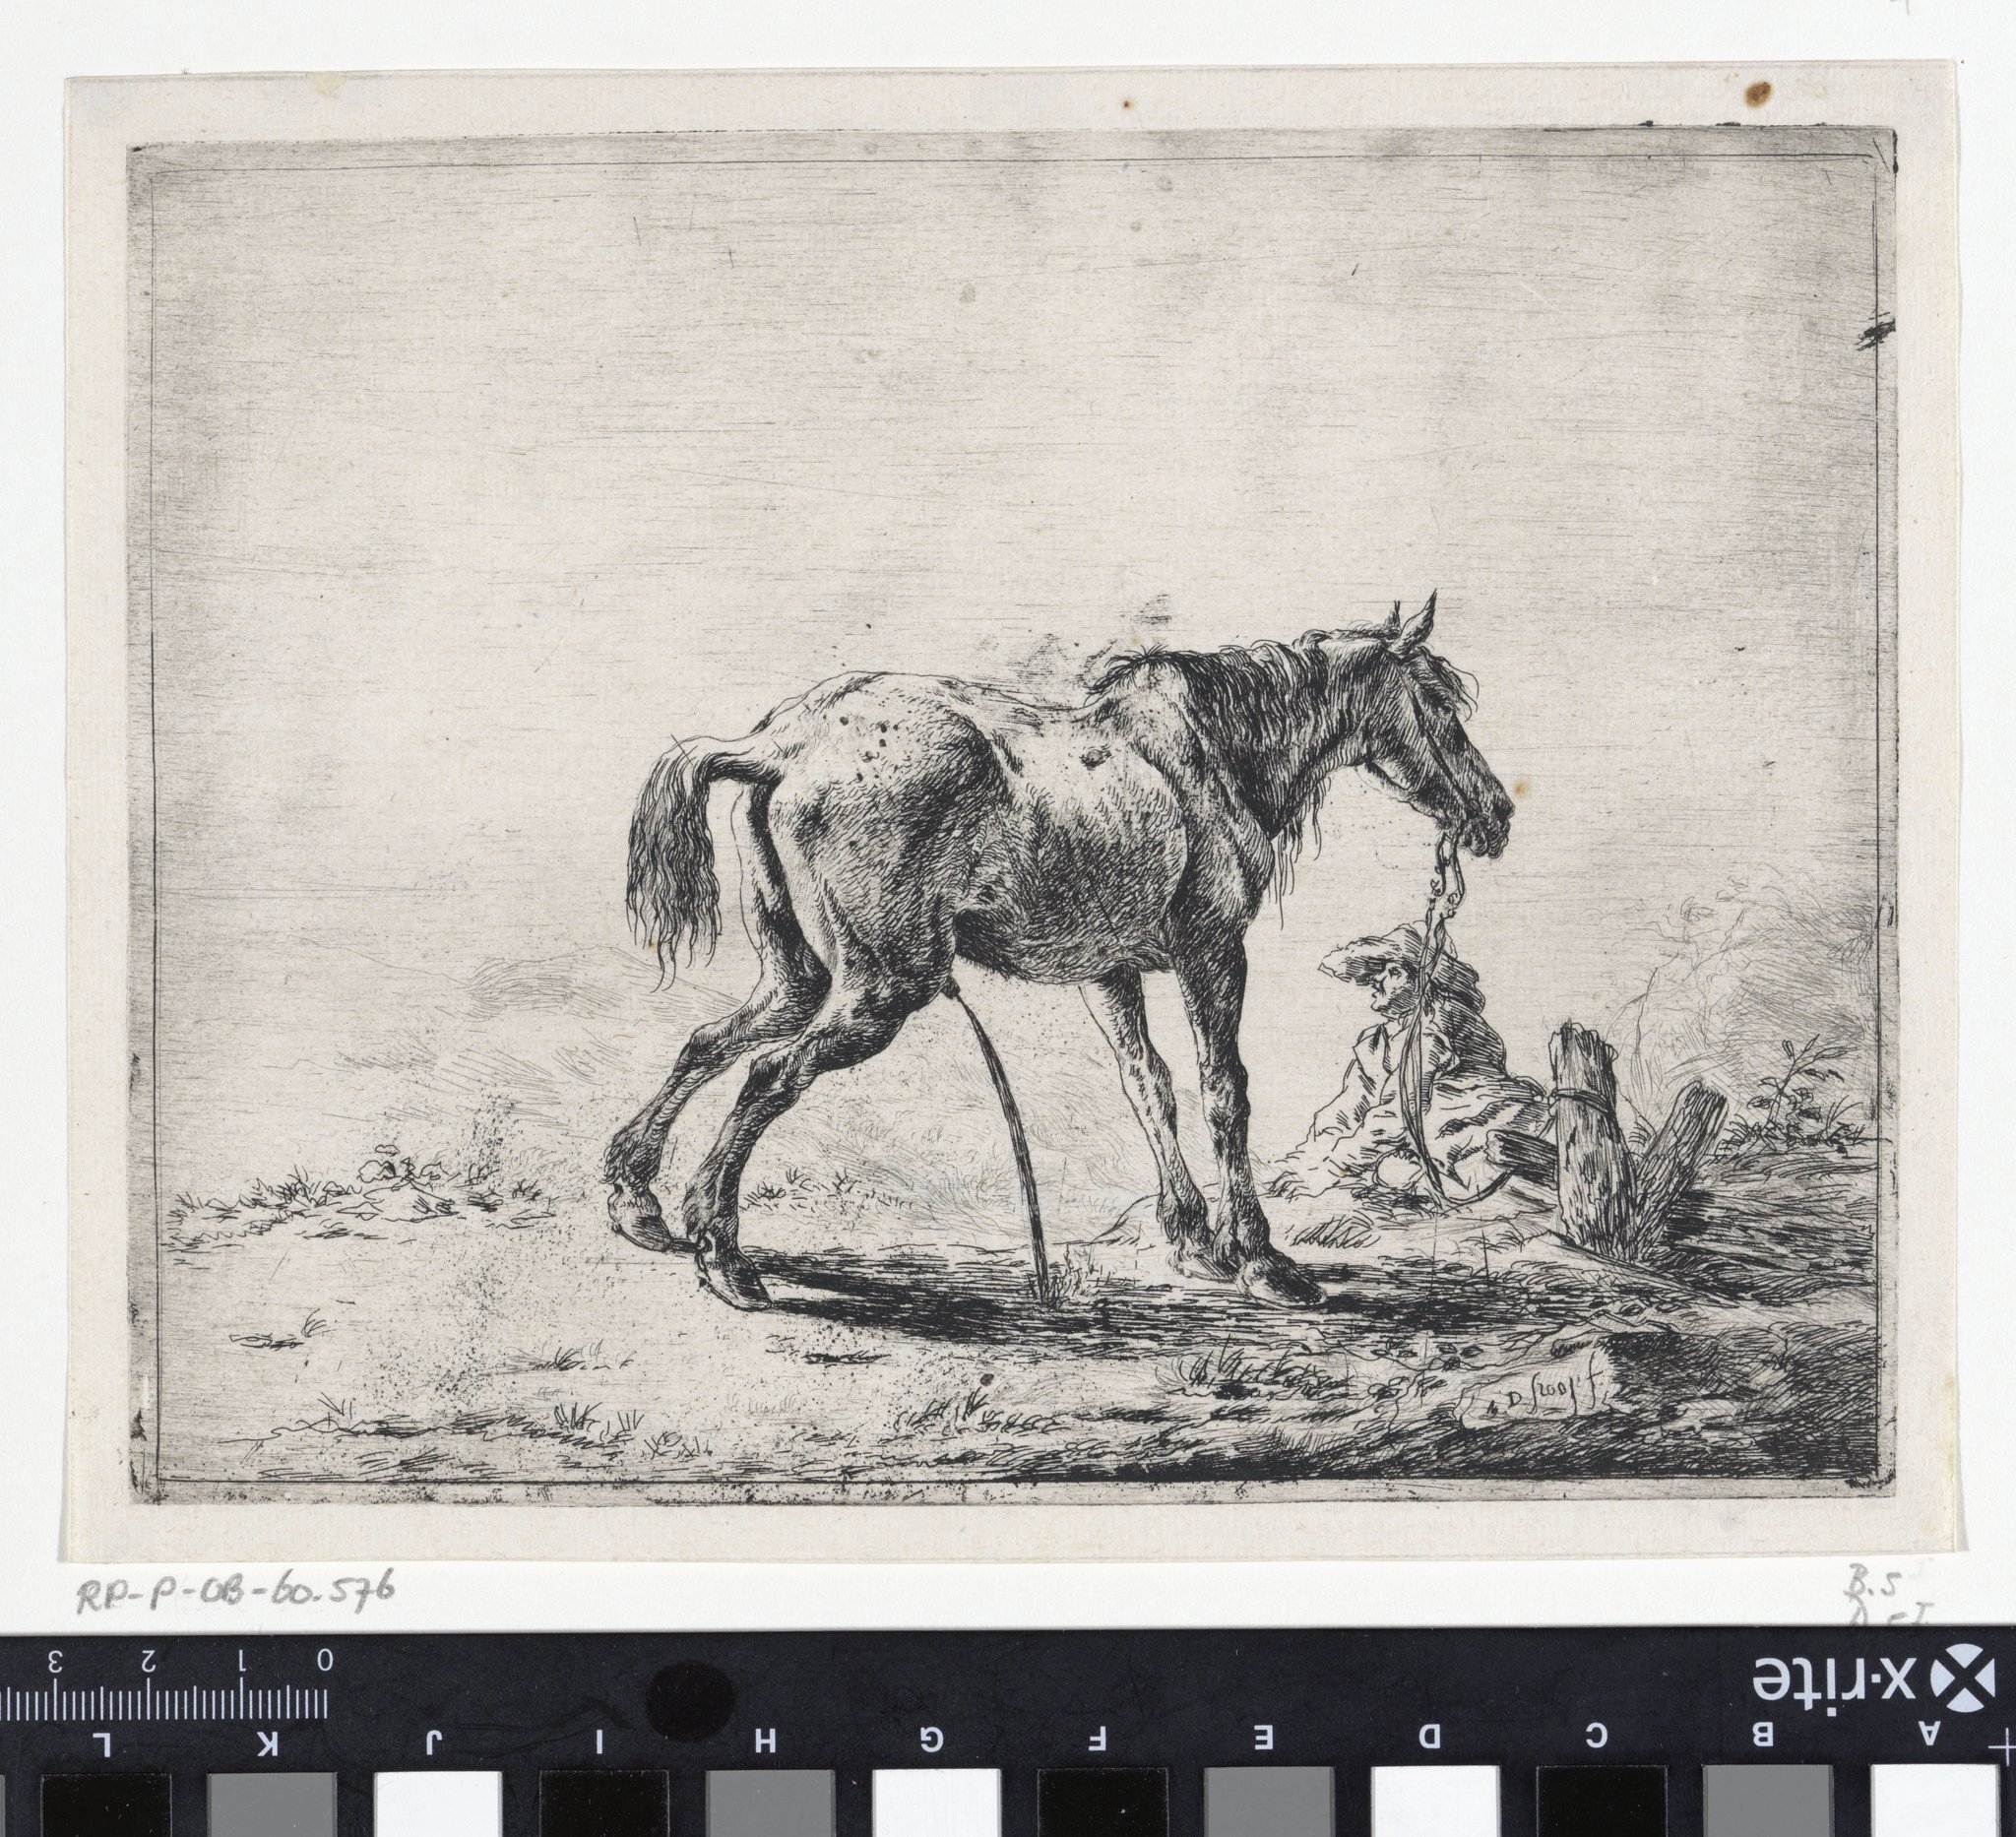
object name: print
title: Paarden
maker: dirk stoop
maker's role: draughtsman, painter, print maker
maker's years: 1615-1686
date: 1651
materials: paper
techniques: etching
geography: utrecht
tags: horse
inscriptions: collector's mark: Lugt 240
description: Een pissend paard, vastgebonden aan een paal. Rechts de rustende ruiter.